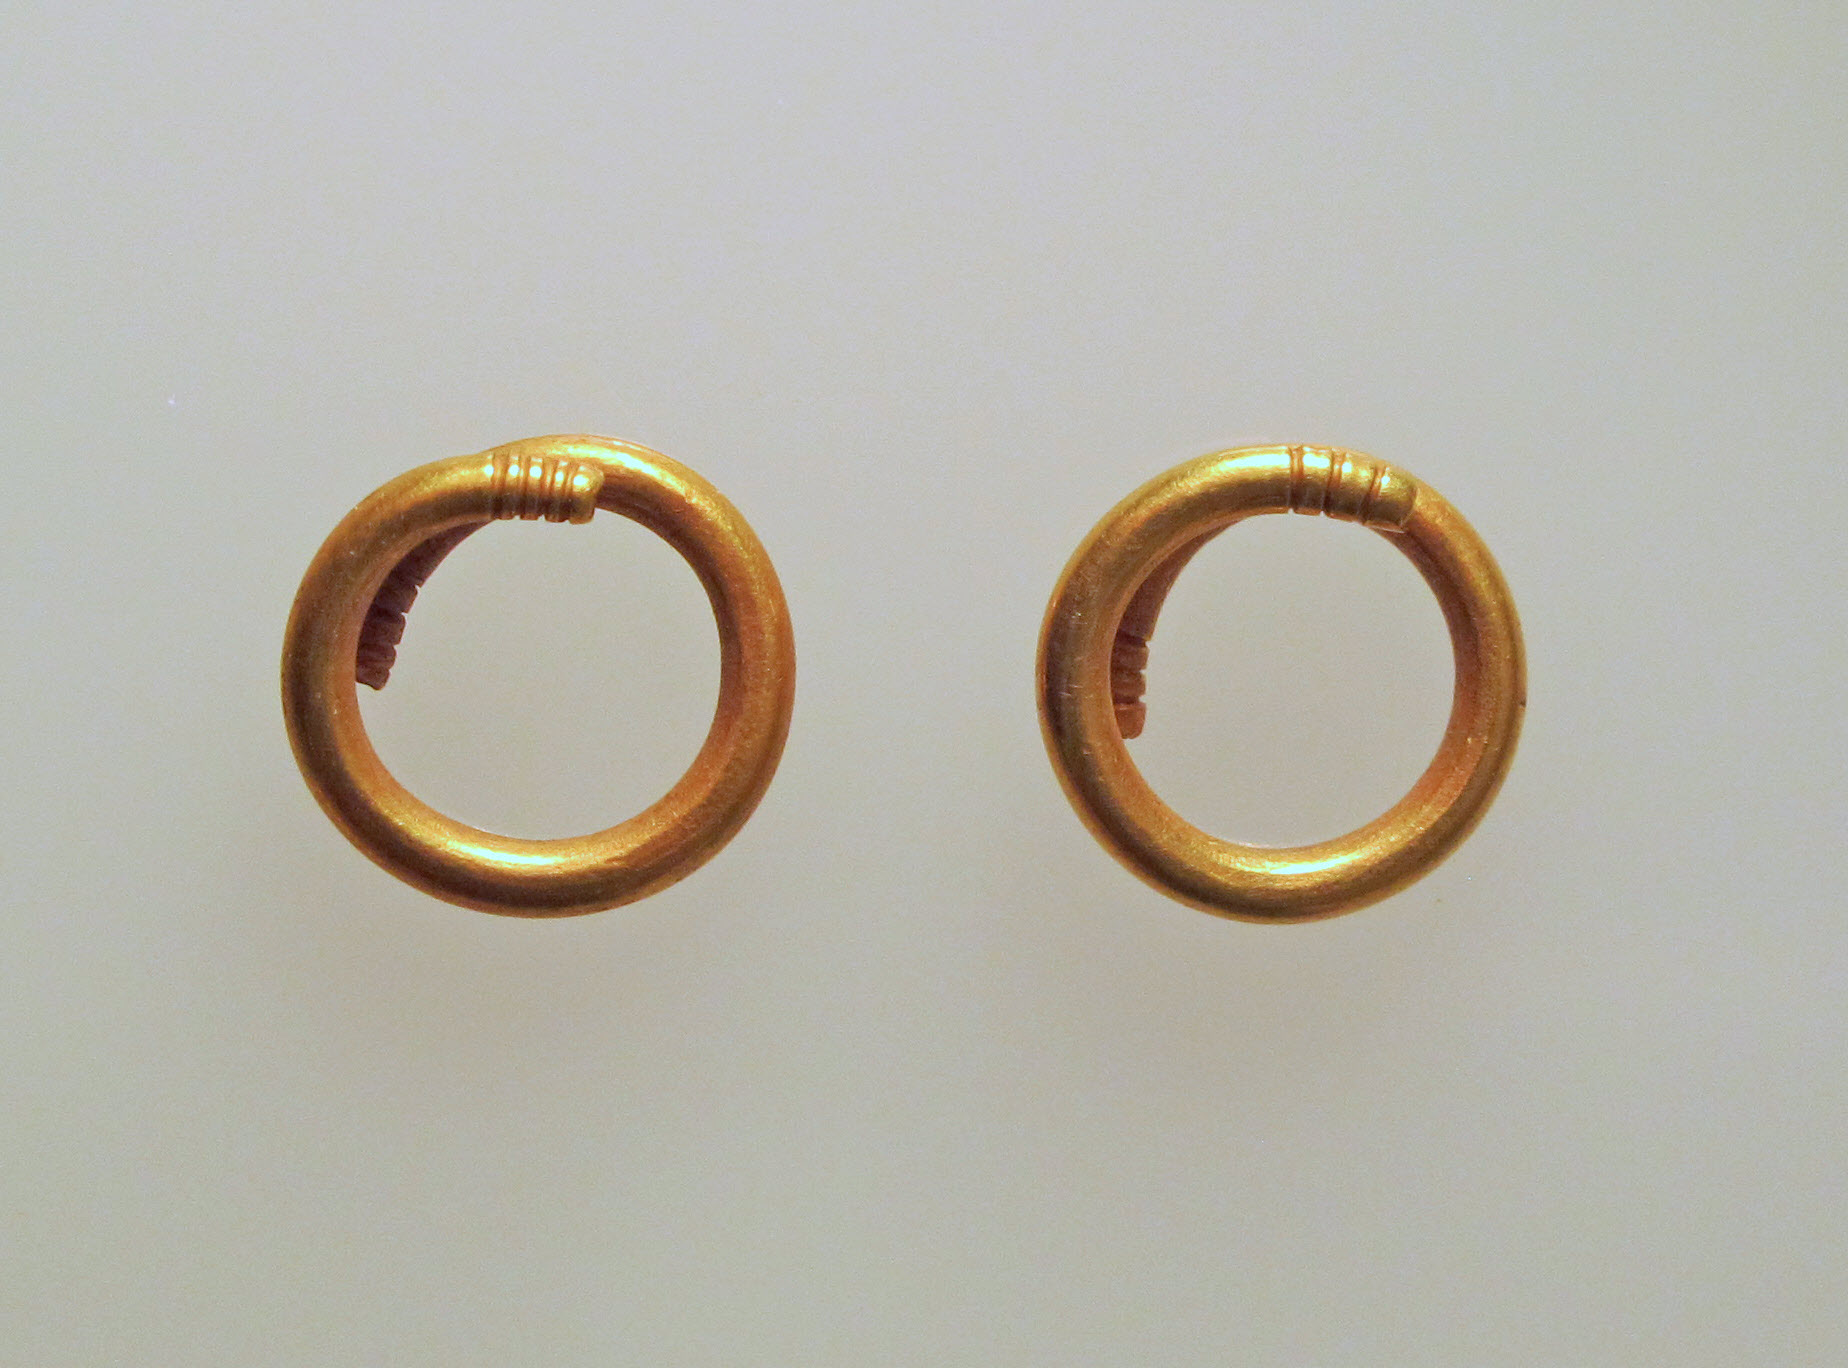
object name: spiral, 18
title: Spirals, 18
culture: cypriot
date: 3900 BCE-100 CE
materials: gold